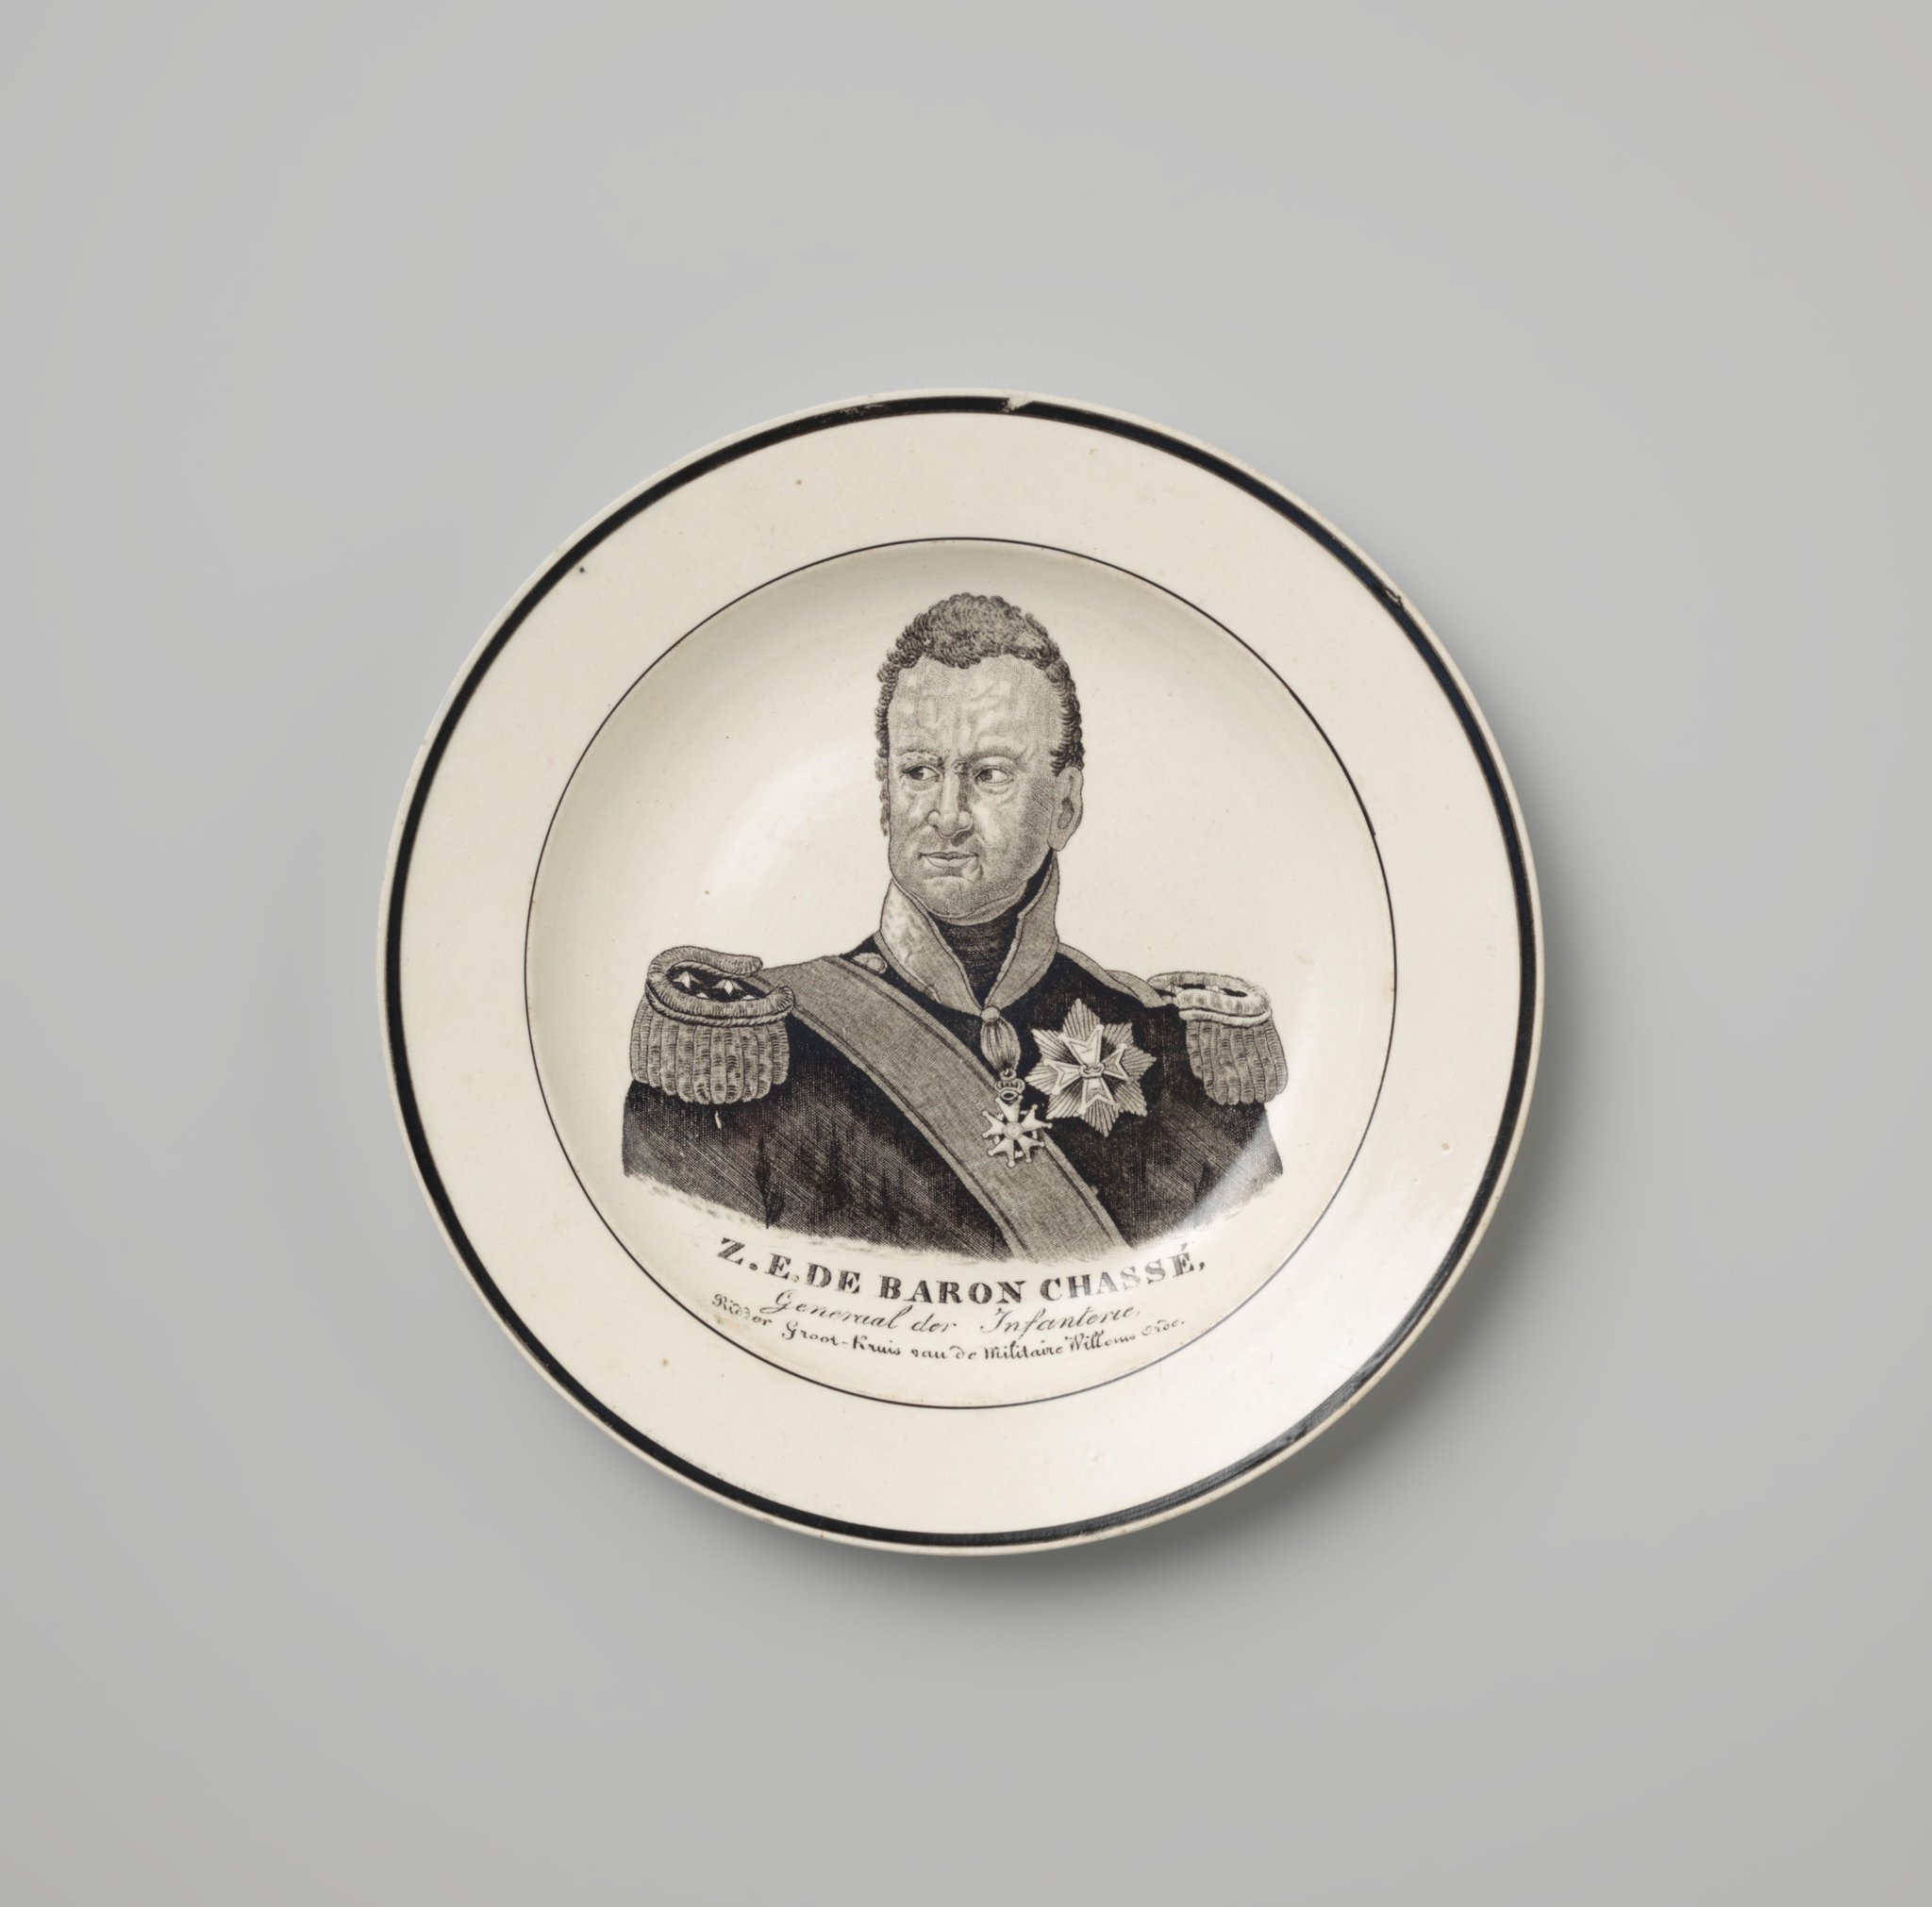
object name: plate dish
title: Strijd om de Citadel van Antwerpen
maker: Anonymous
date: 1832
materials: earthenware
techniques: firing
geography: england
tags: david hendrik baron chassé, historical persons, antwerp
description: Bord met schuin oplopende rand en portret (borststuk) van man in uniform naar links kijkend in zwart/witte transferprint. Twee onderscheidingstekenen (w. o. Militaire Willemsorde), sjerp en epauletten. Twee zwarte lijnen langs de rand.